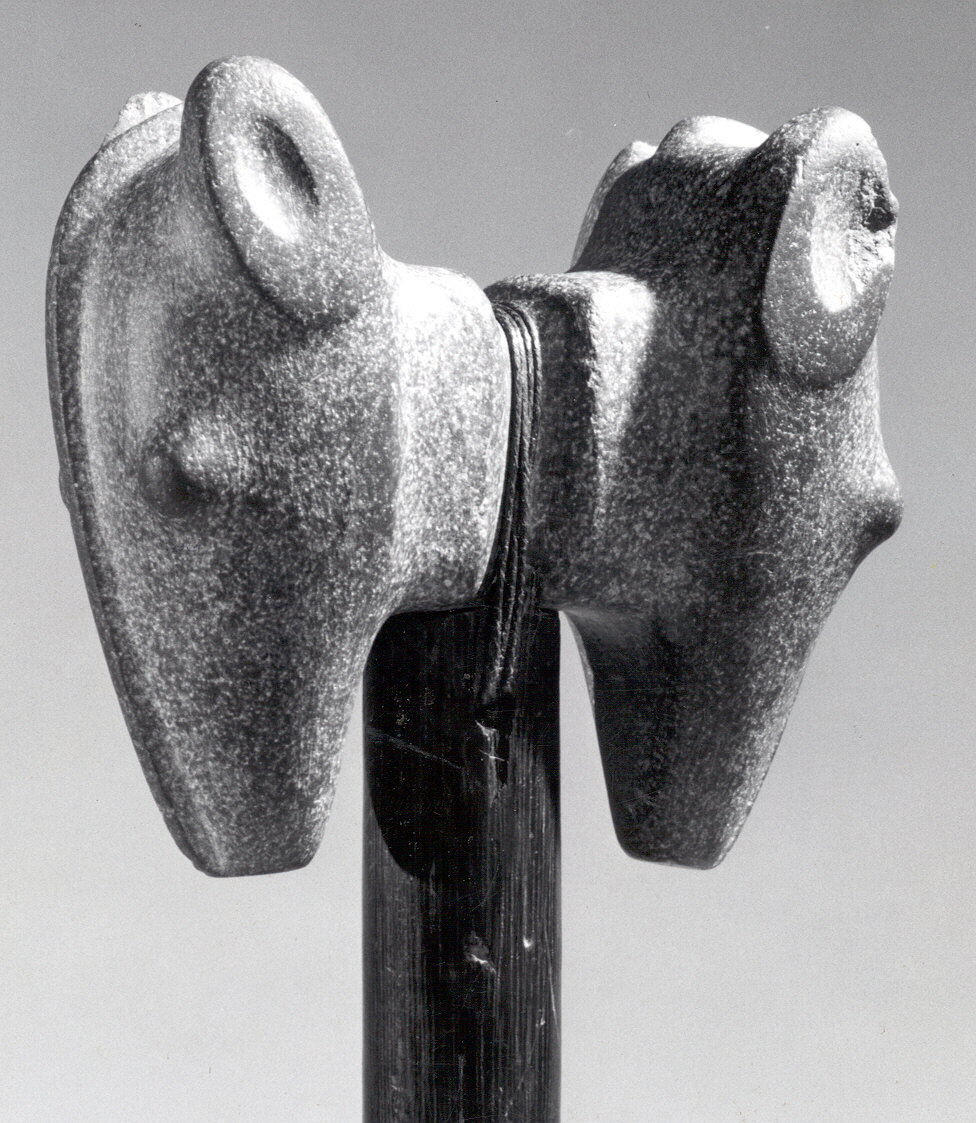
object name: mace head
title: Stone Janus Mace Head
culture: michoacan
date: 1001-1600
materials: stone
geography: mexico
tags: weapons